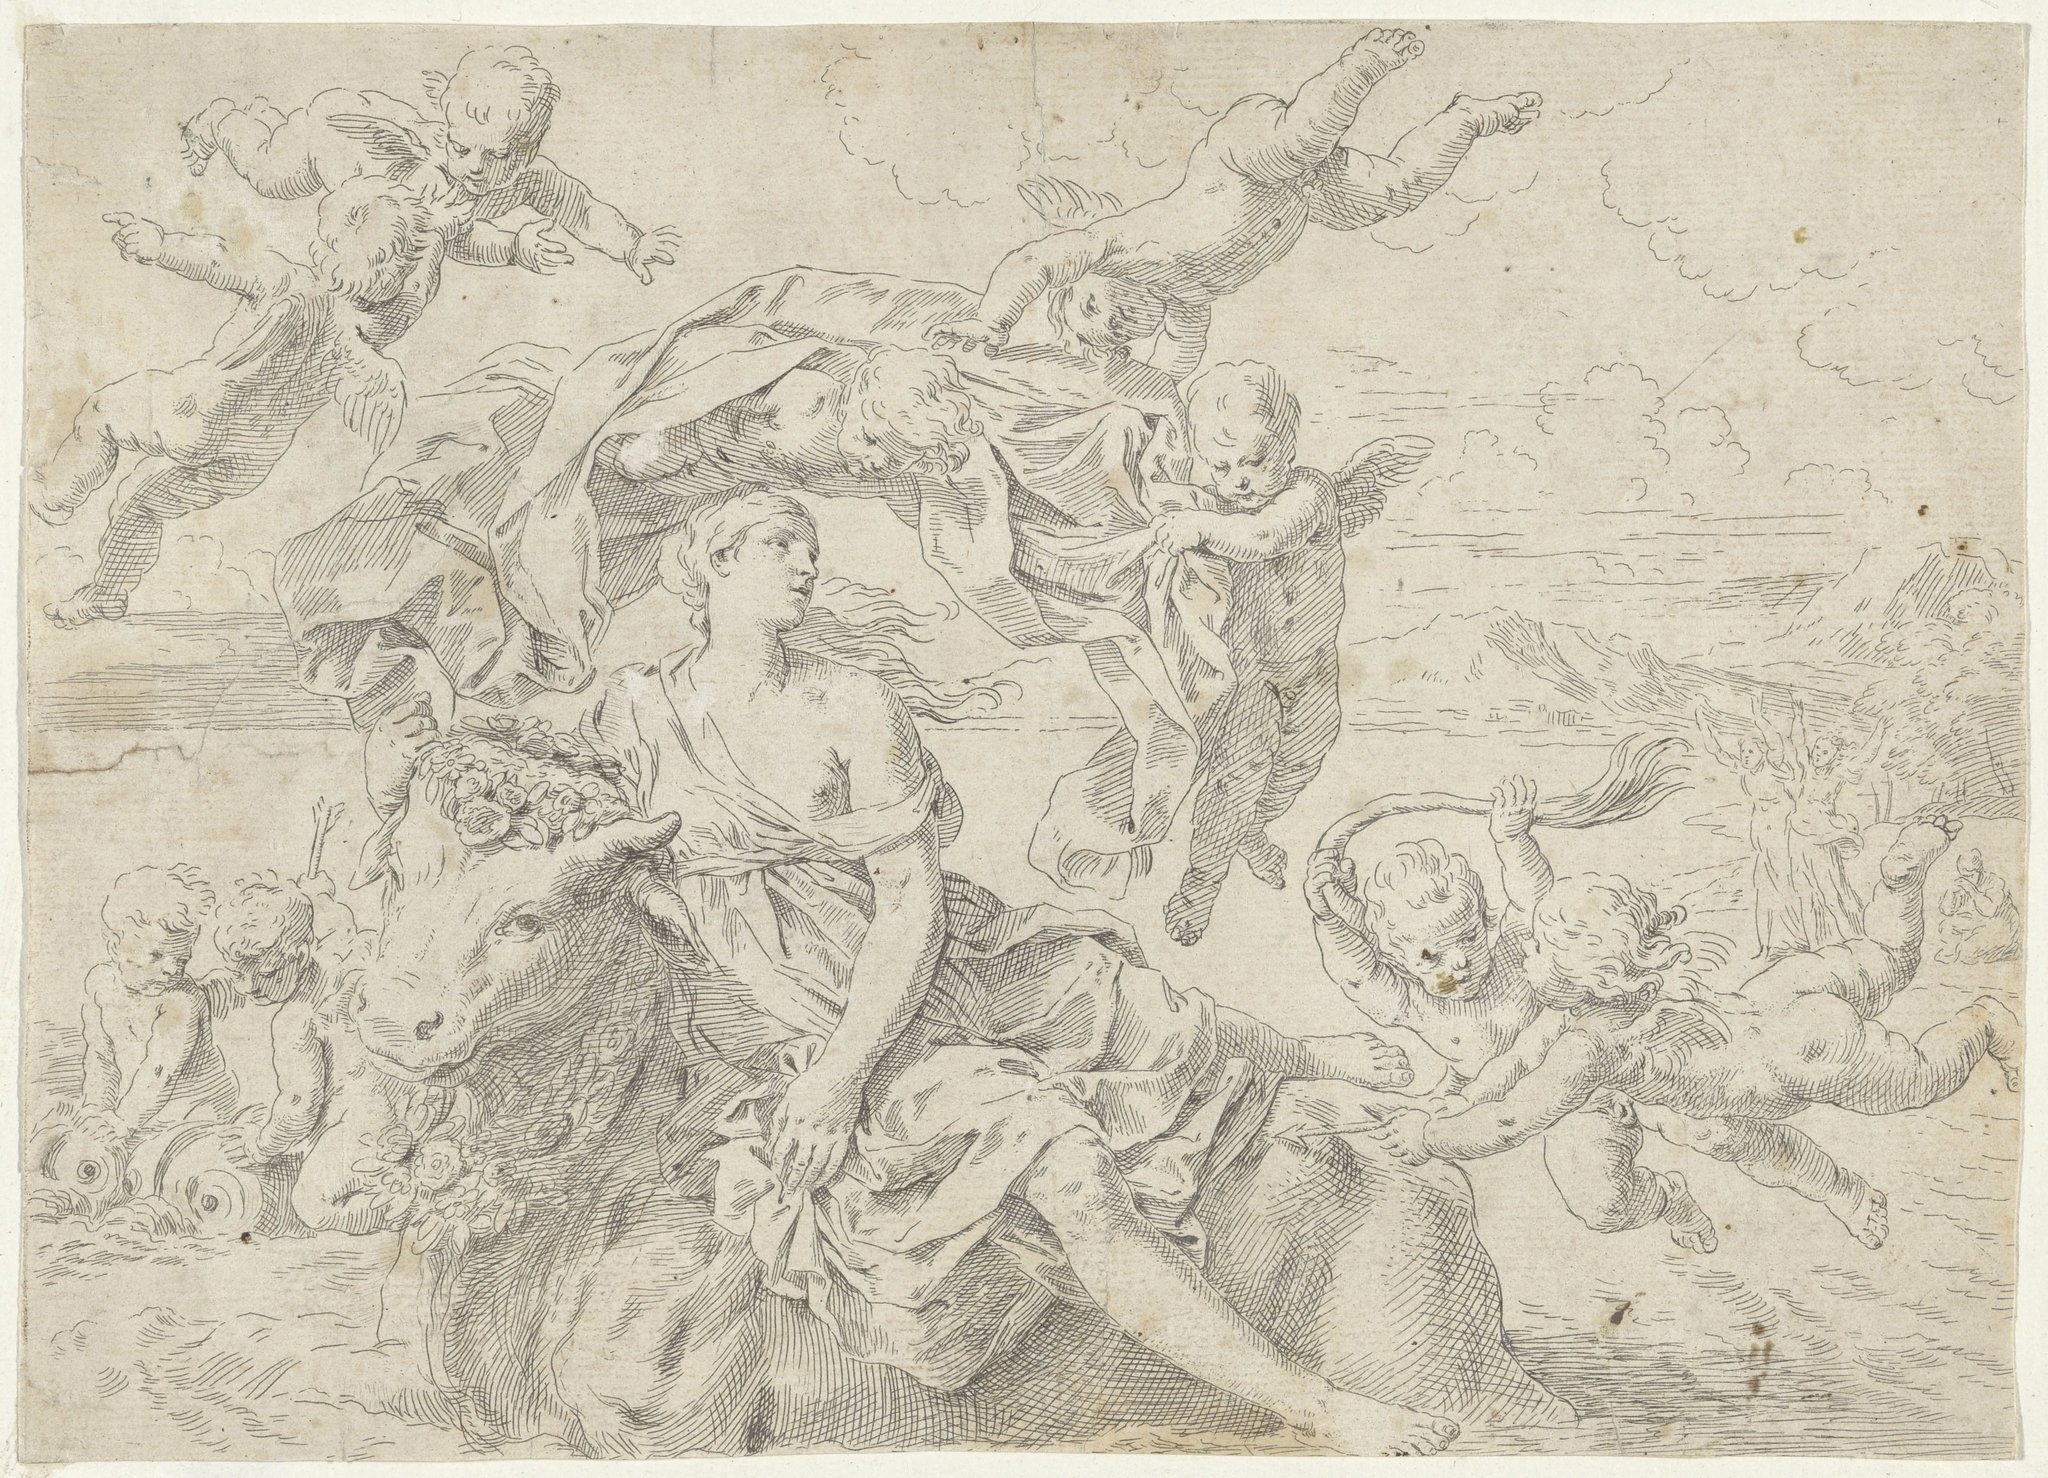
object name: print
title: Roof van Europa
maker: simone cantarini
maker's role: draughtsman, print maker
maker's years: 1612-1648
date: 1622-1648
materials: paper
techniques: printmaking, etching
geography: italy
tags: jupiter, usually in the shape of a white bull, abducts europa and carries her across the water, cupids: 'amores', 'amoretti', 'putti'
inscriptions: collector's mark: Lugt 2228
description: Jupiter, in de gedaante van een stier, voert Europa op zijn rug mee door de zee. In de lucht zweven putti. De dienstmaagden van Europa staan op de kust.